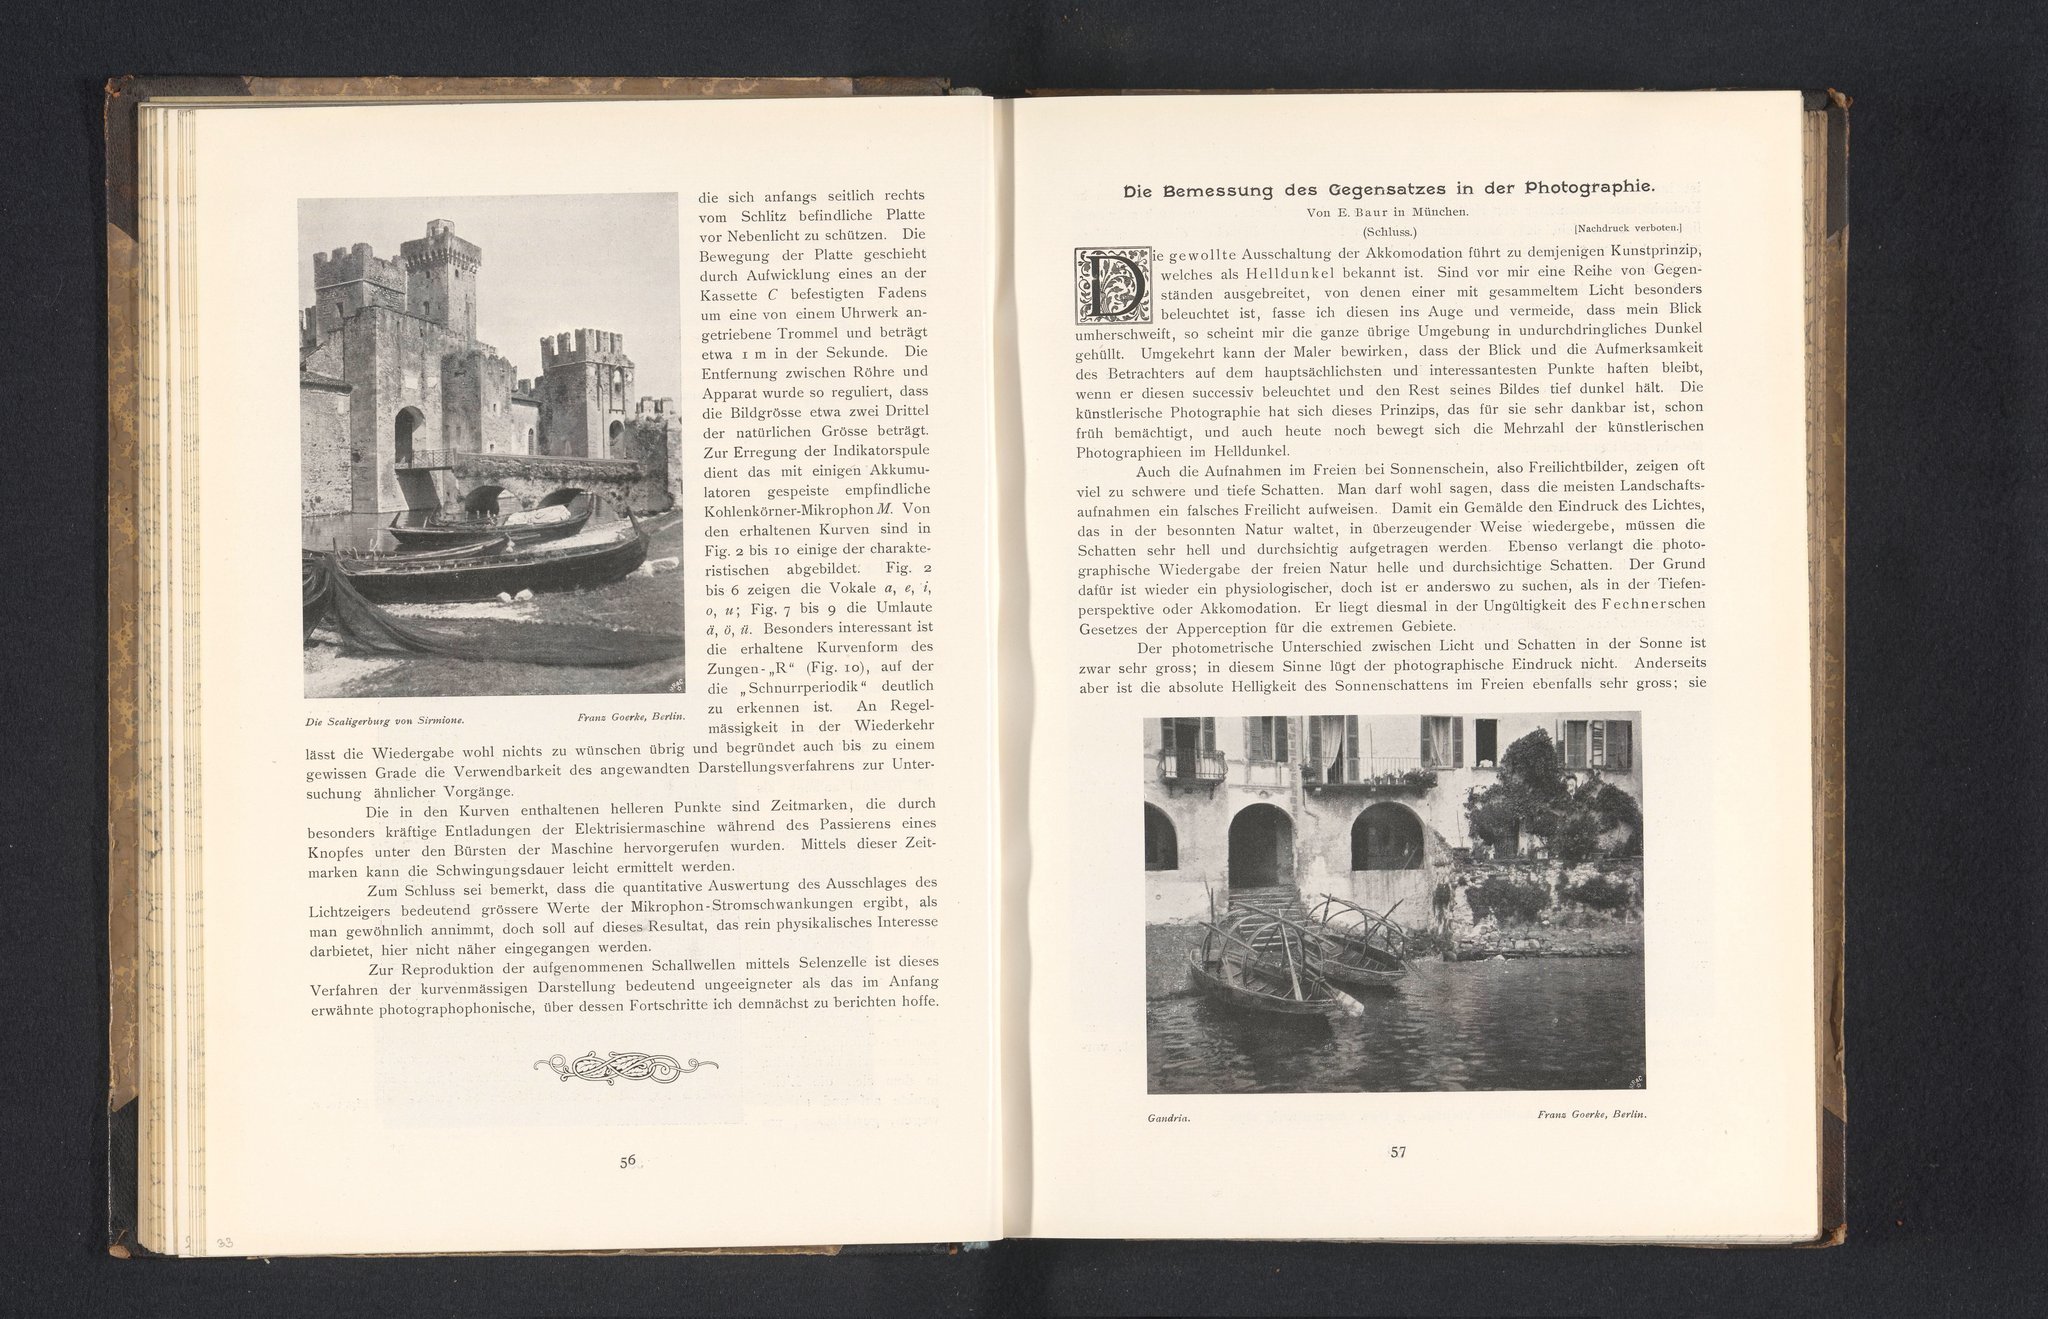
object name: photomechanical print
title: Die Scaligerburg von Sirmione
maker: franz goerke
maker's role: fotograaf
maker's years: 1856-1931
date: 1898-1903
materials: paper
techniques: autotype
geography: berlin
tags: castle